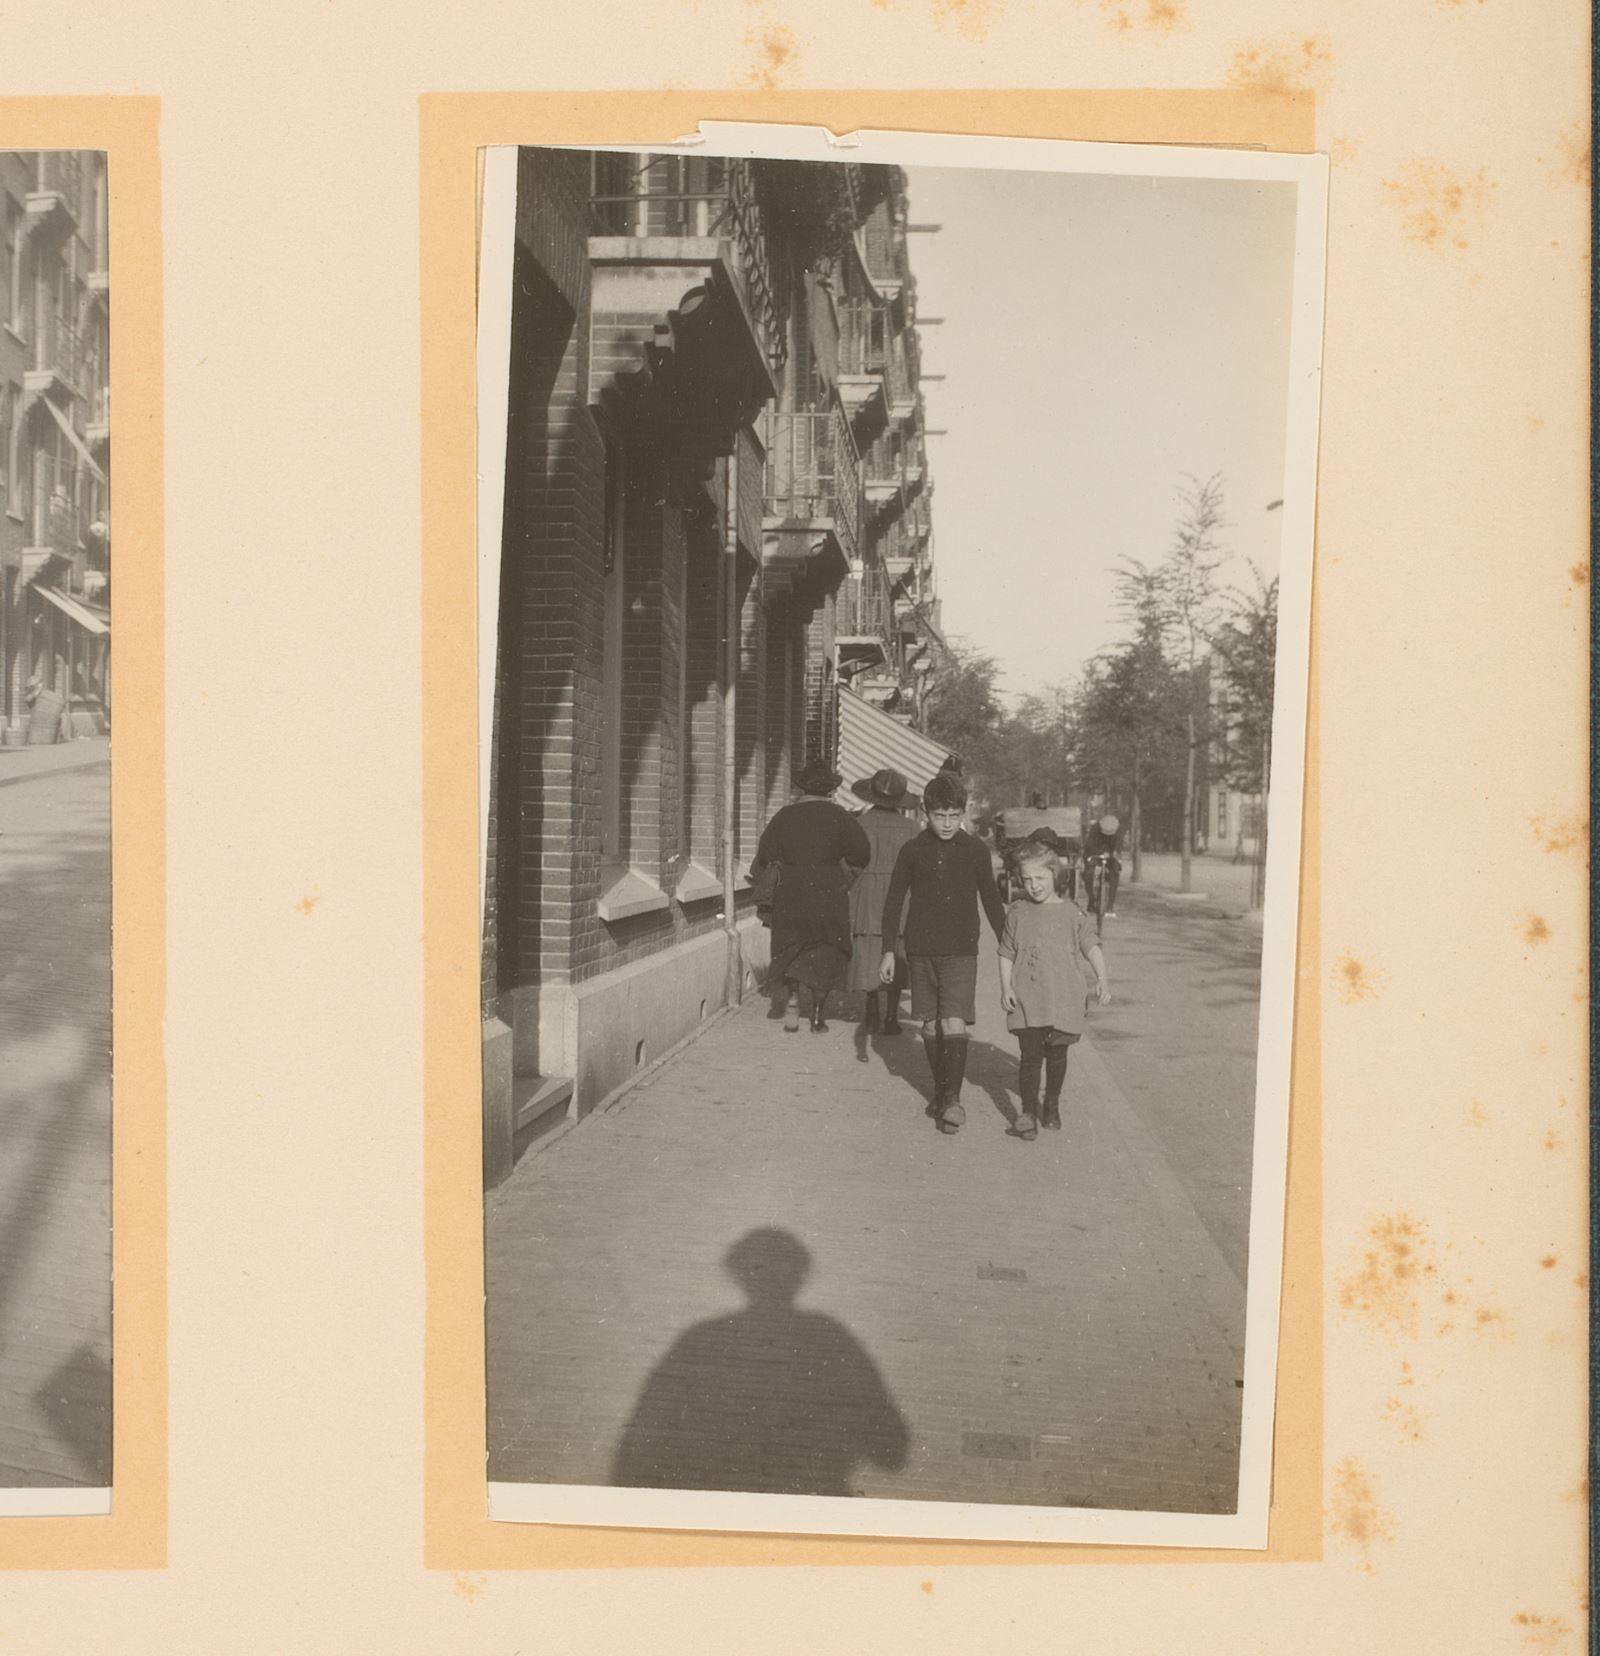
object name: album leaf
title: Portret van een meisje in een Nederlandse straat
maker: Anonymous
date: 1927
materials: paper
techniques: gelatin silver print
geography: netherlands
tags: girl (child between toddler and youth), anonymous historical person portrayed, street, netherlands